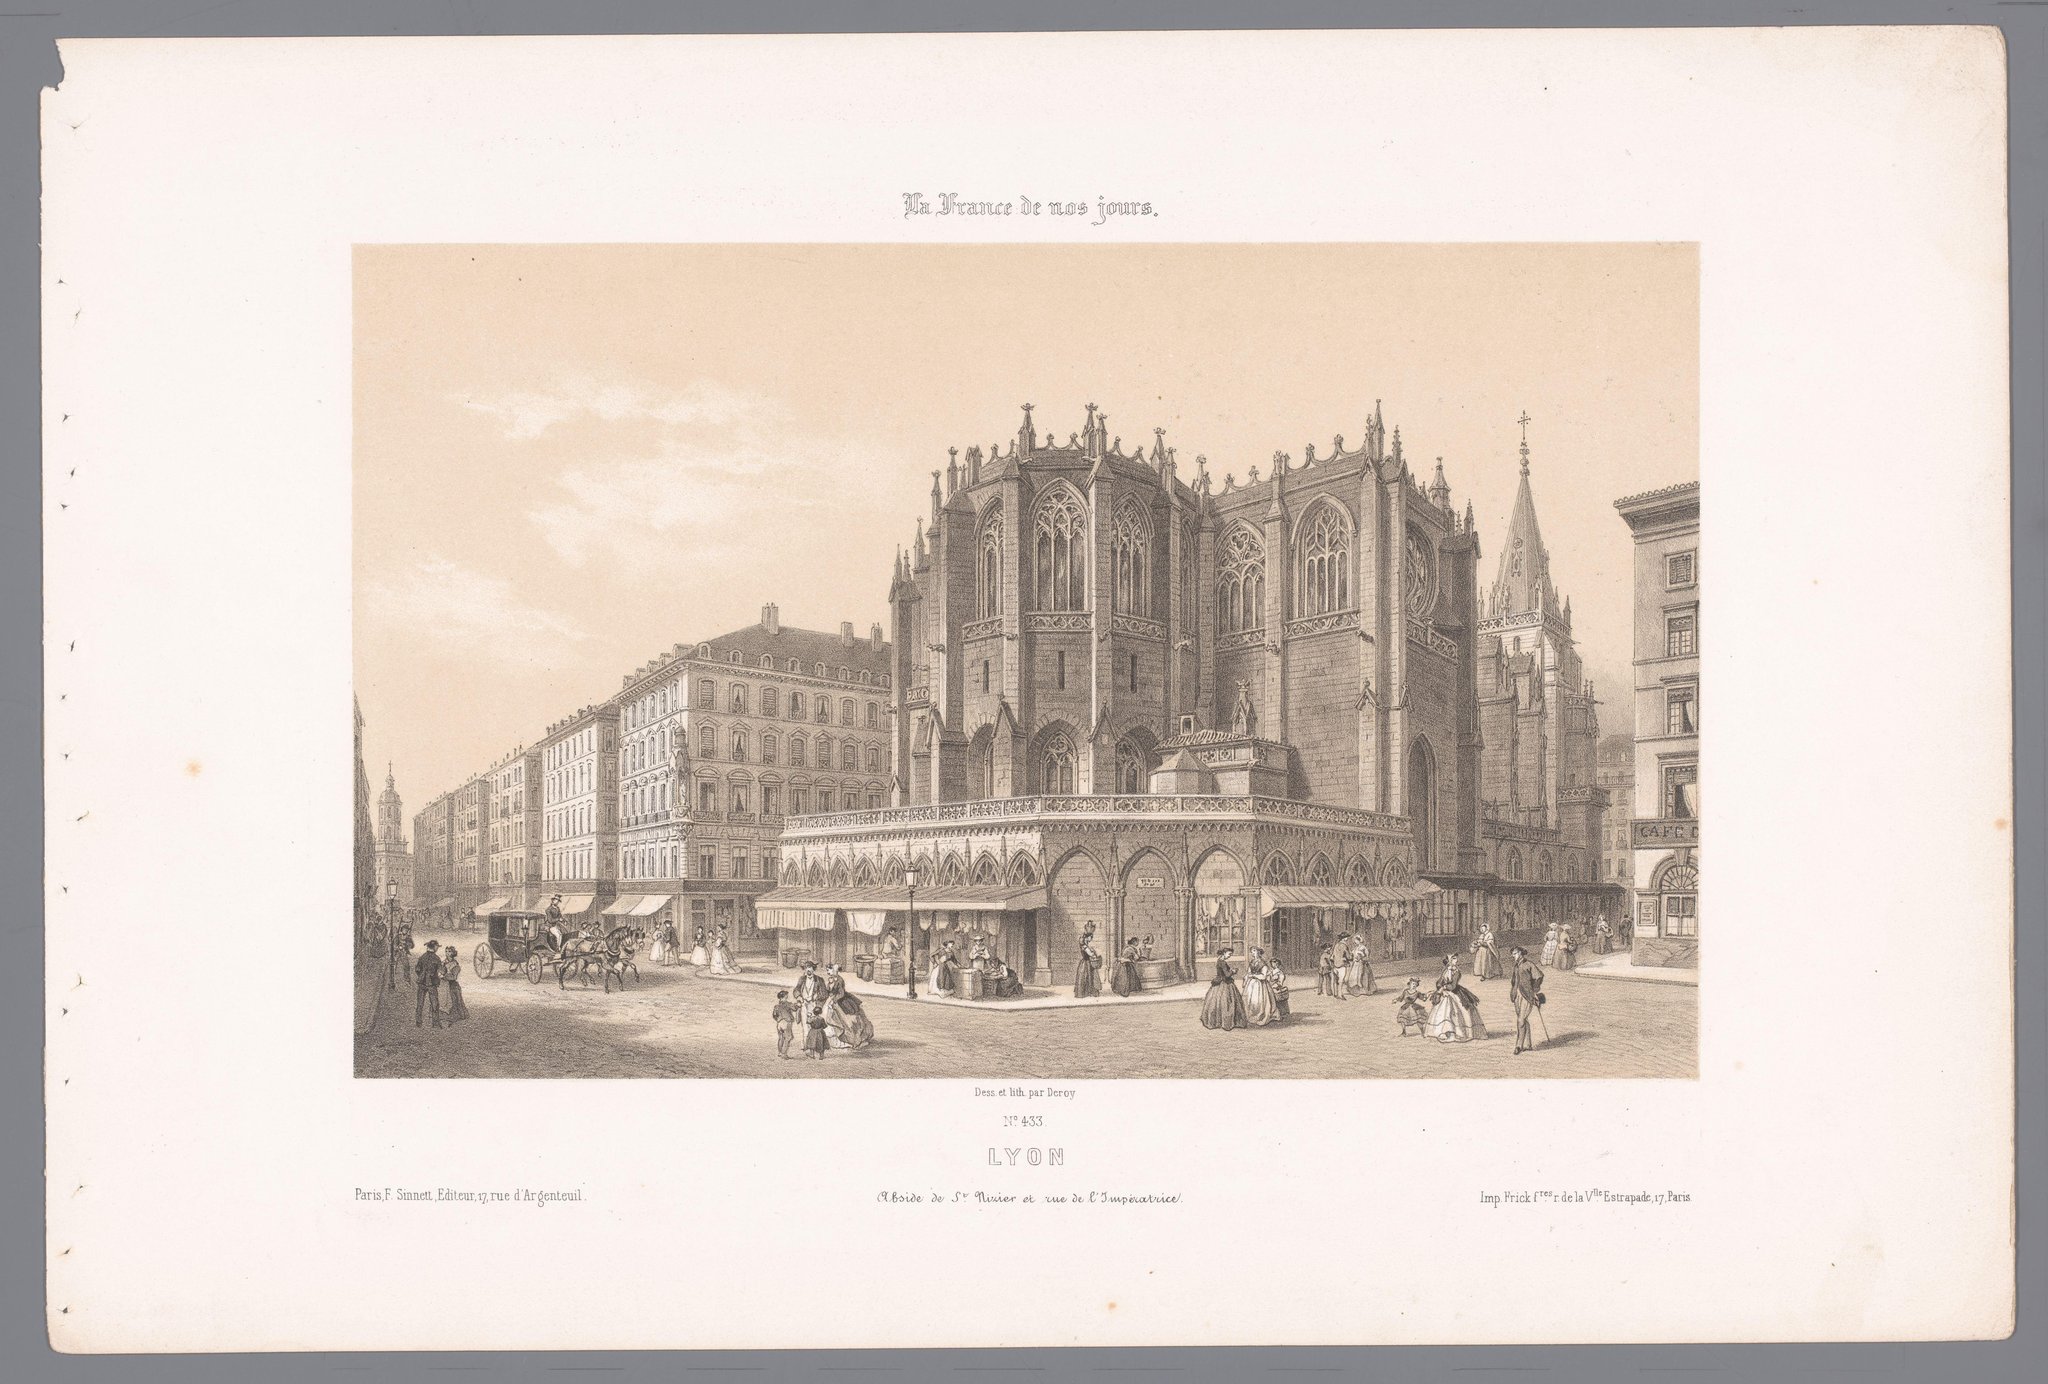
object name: print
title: Lyon. Abside de St. Nizier et rue de l'Impératrice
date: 1861-1872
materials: paper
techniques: tone lithography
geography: paris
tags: church (exterior), street (+ city(-scape) with figures, staffage)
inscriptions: collector's mark: Lugt 2228a